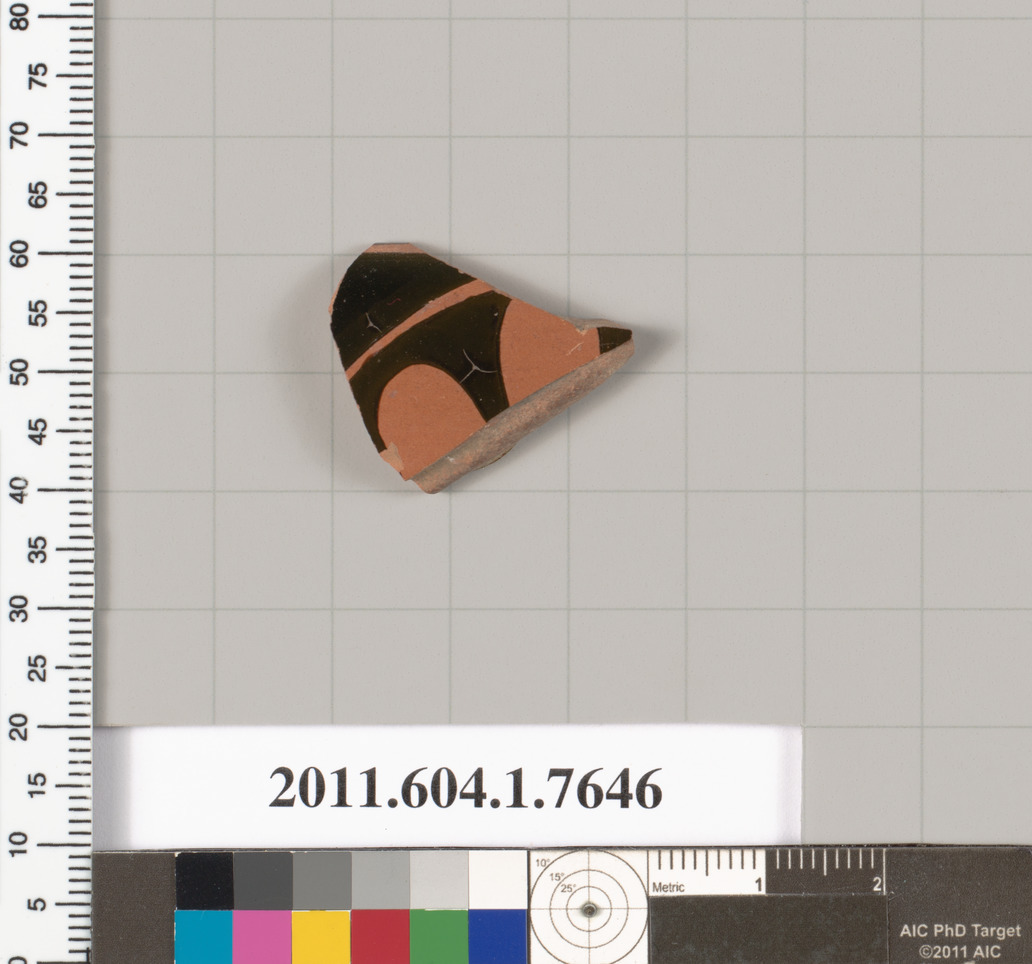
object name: kylix fragment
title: Terracotta rim fragment of a kylix (drinking cup)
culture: greek, attic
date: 490-480 BCE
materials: terracotta